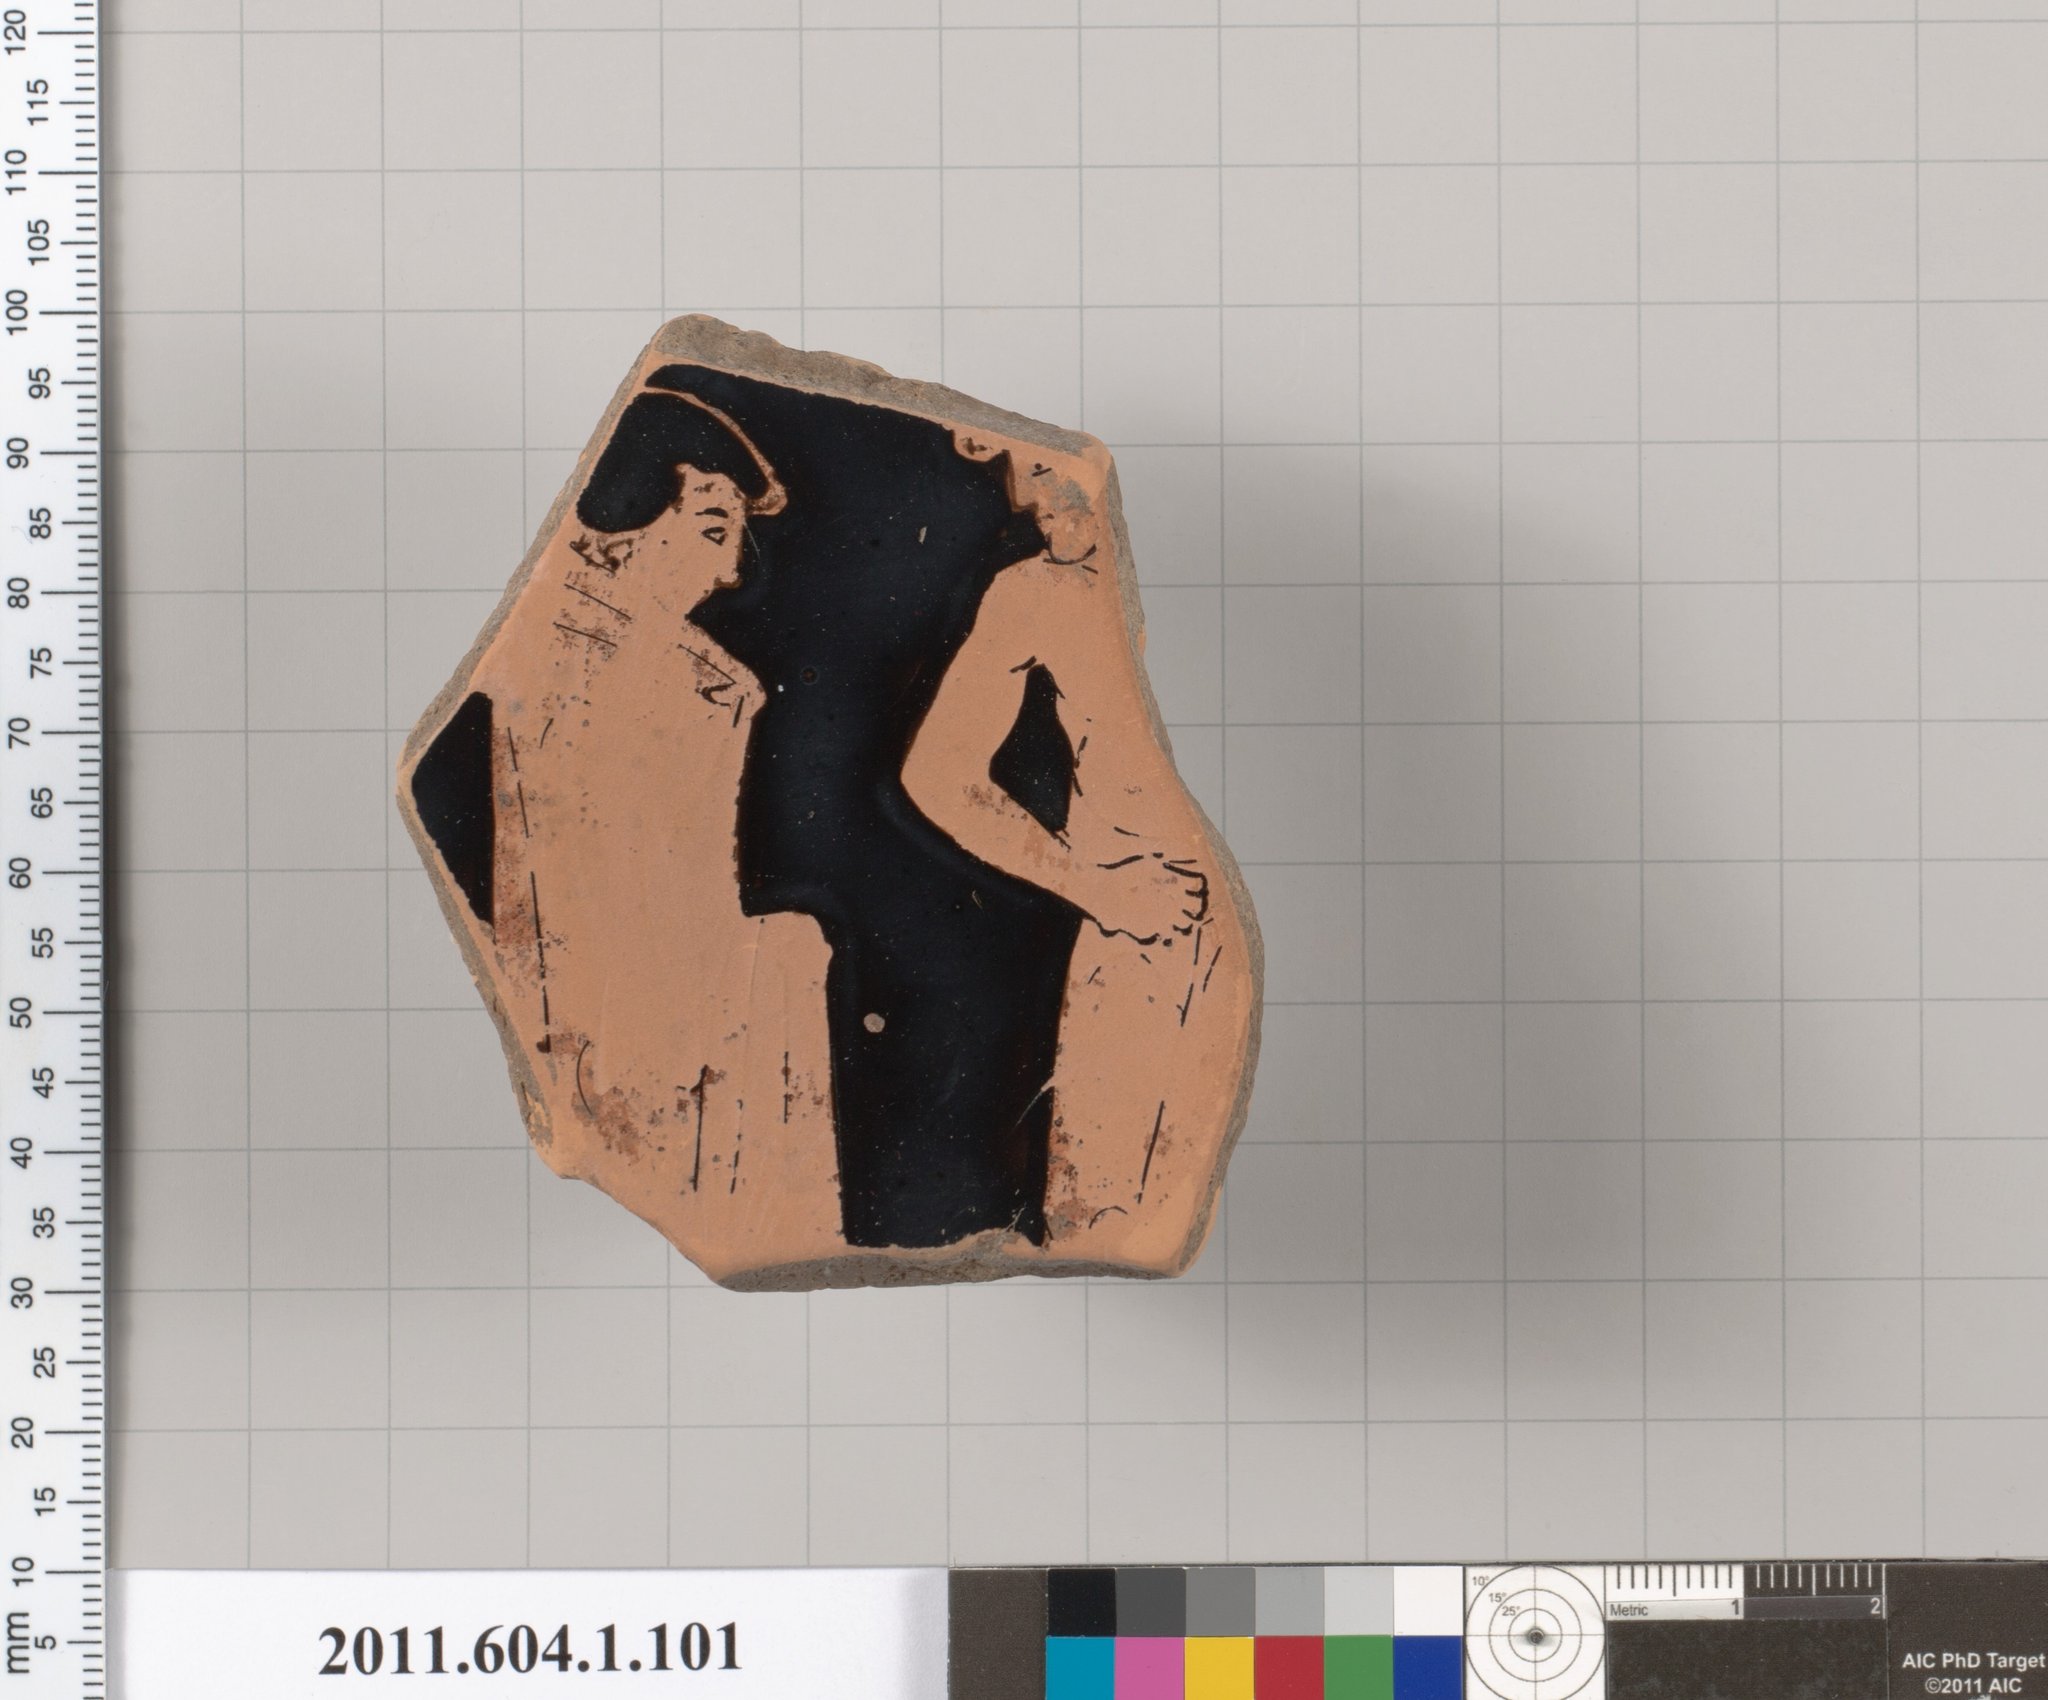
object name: kylix fragment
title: Terracotta fragment of a kylix (drinking cup)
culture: greek, attic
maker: splanchnopt painter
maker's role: artist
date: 470-450 BCE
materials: terracotta